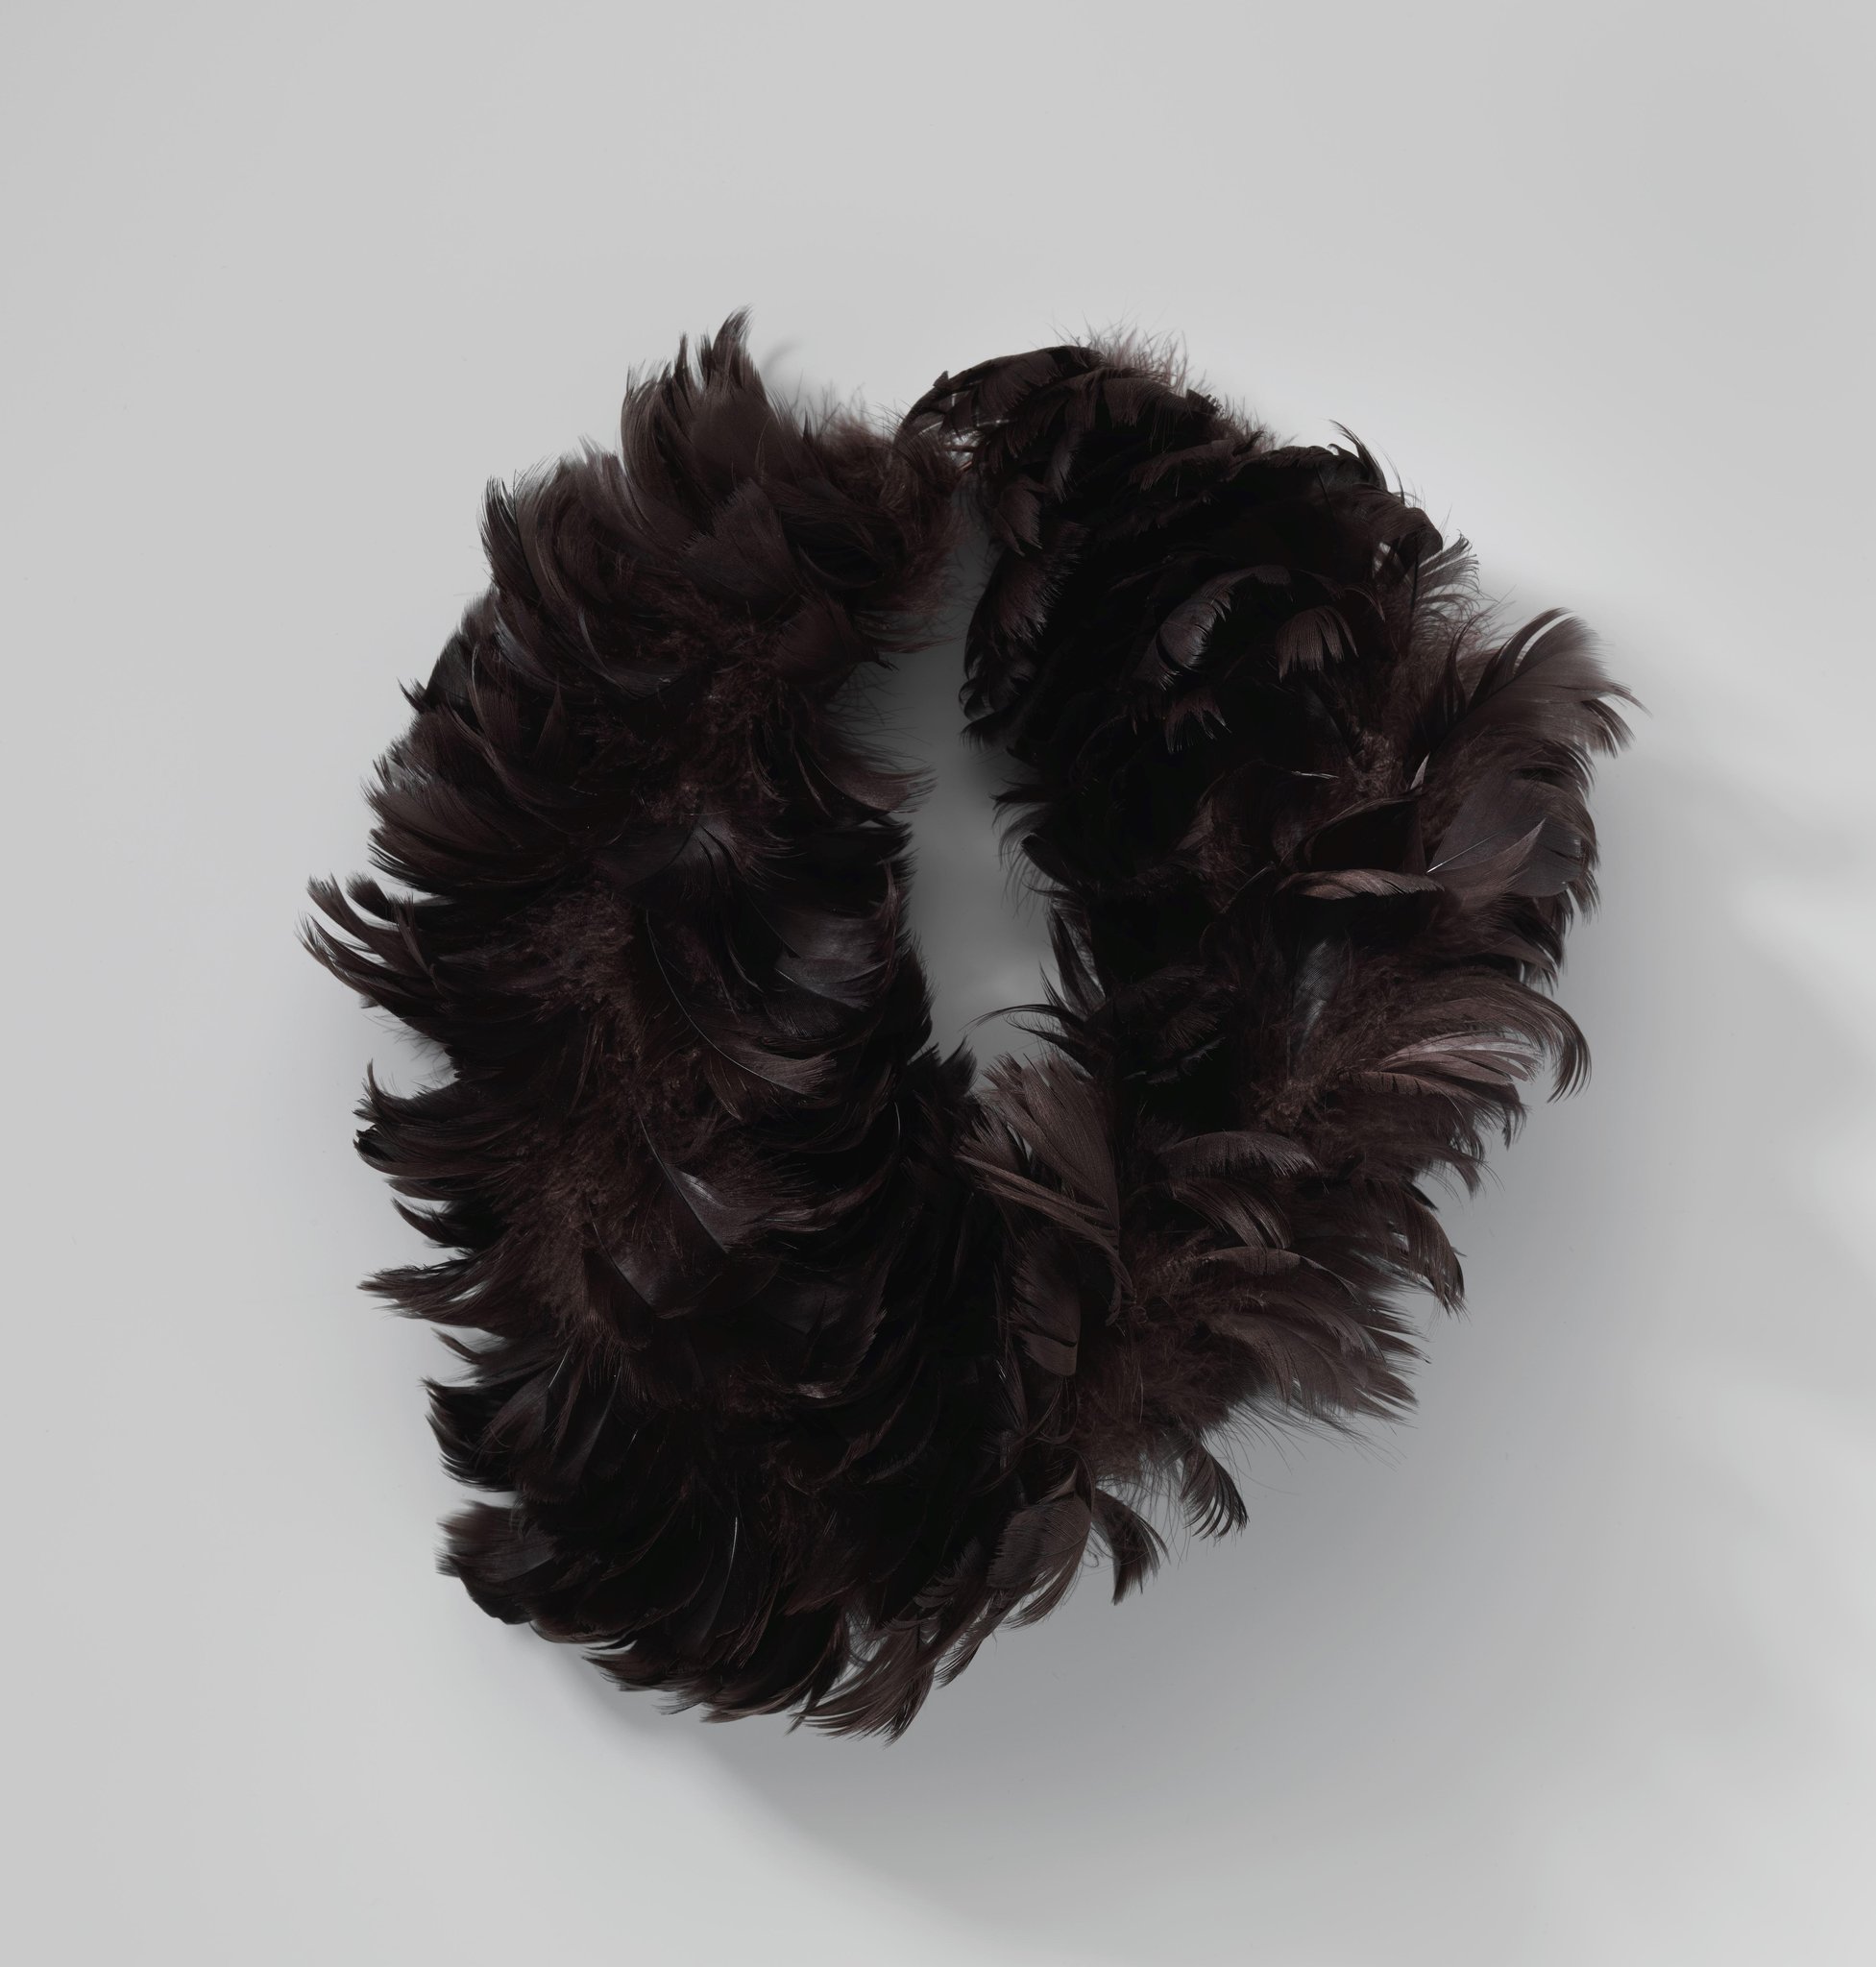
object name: head band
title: Hoofdband van donkerbruine veren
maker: Anonymous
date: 1950-1985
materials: feather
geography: yugoslavia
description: Hoofdband van donkerbruine veren, met winkelprijs bevestigd aan de binnenzijde.